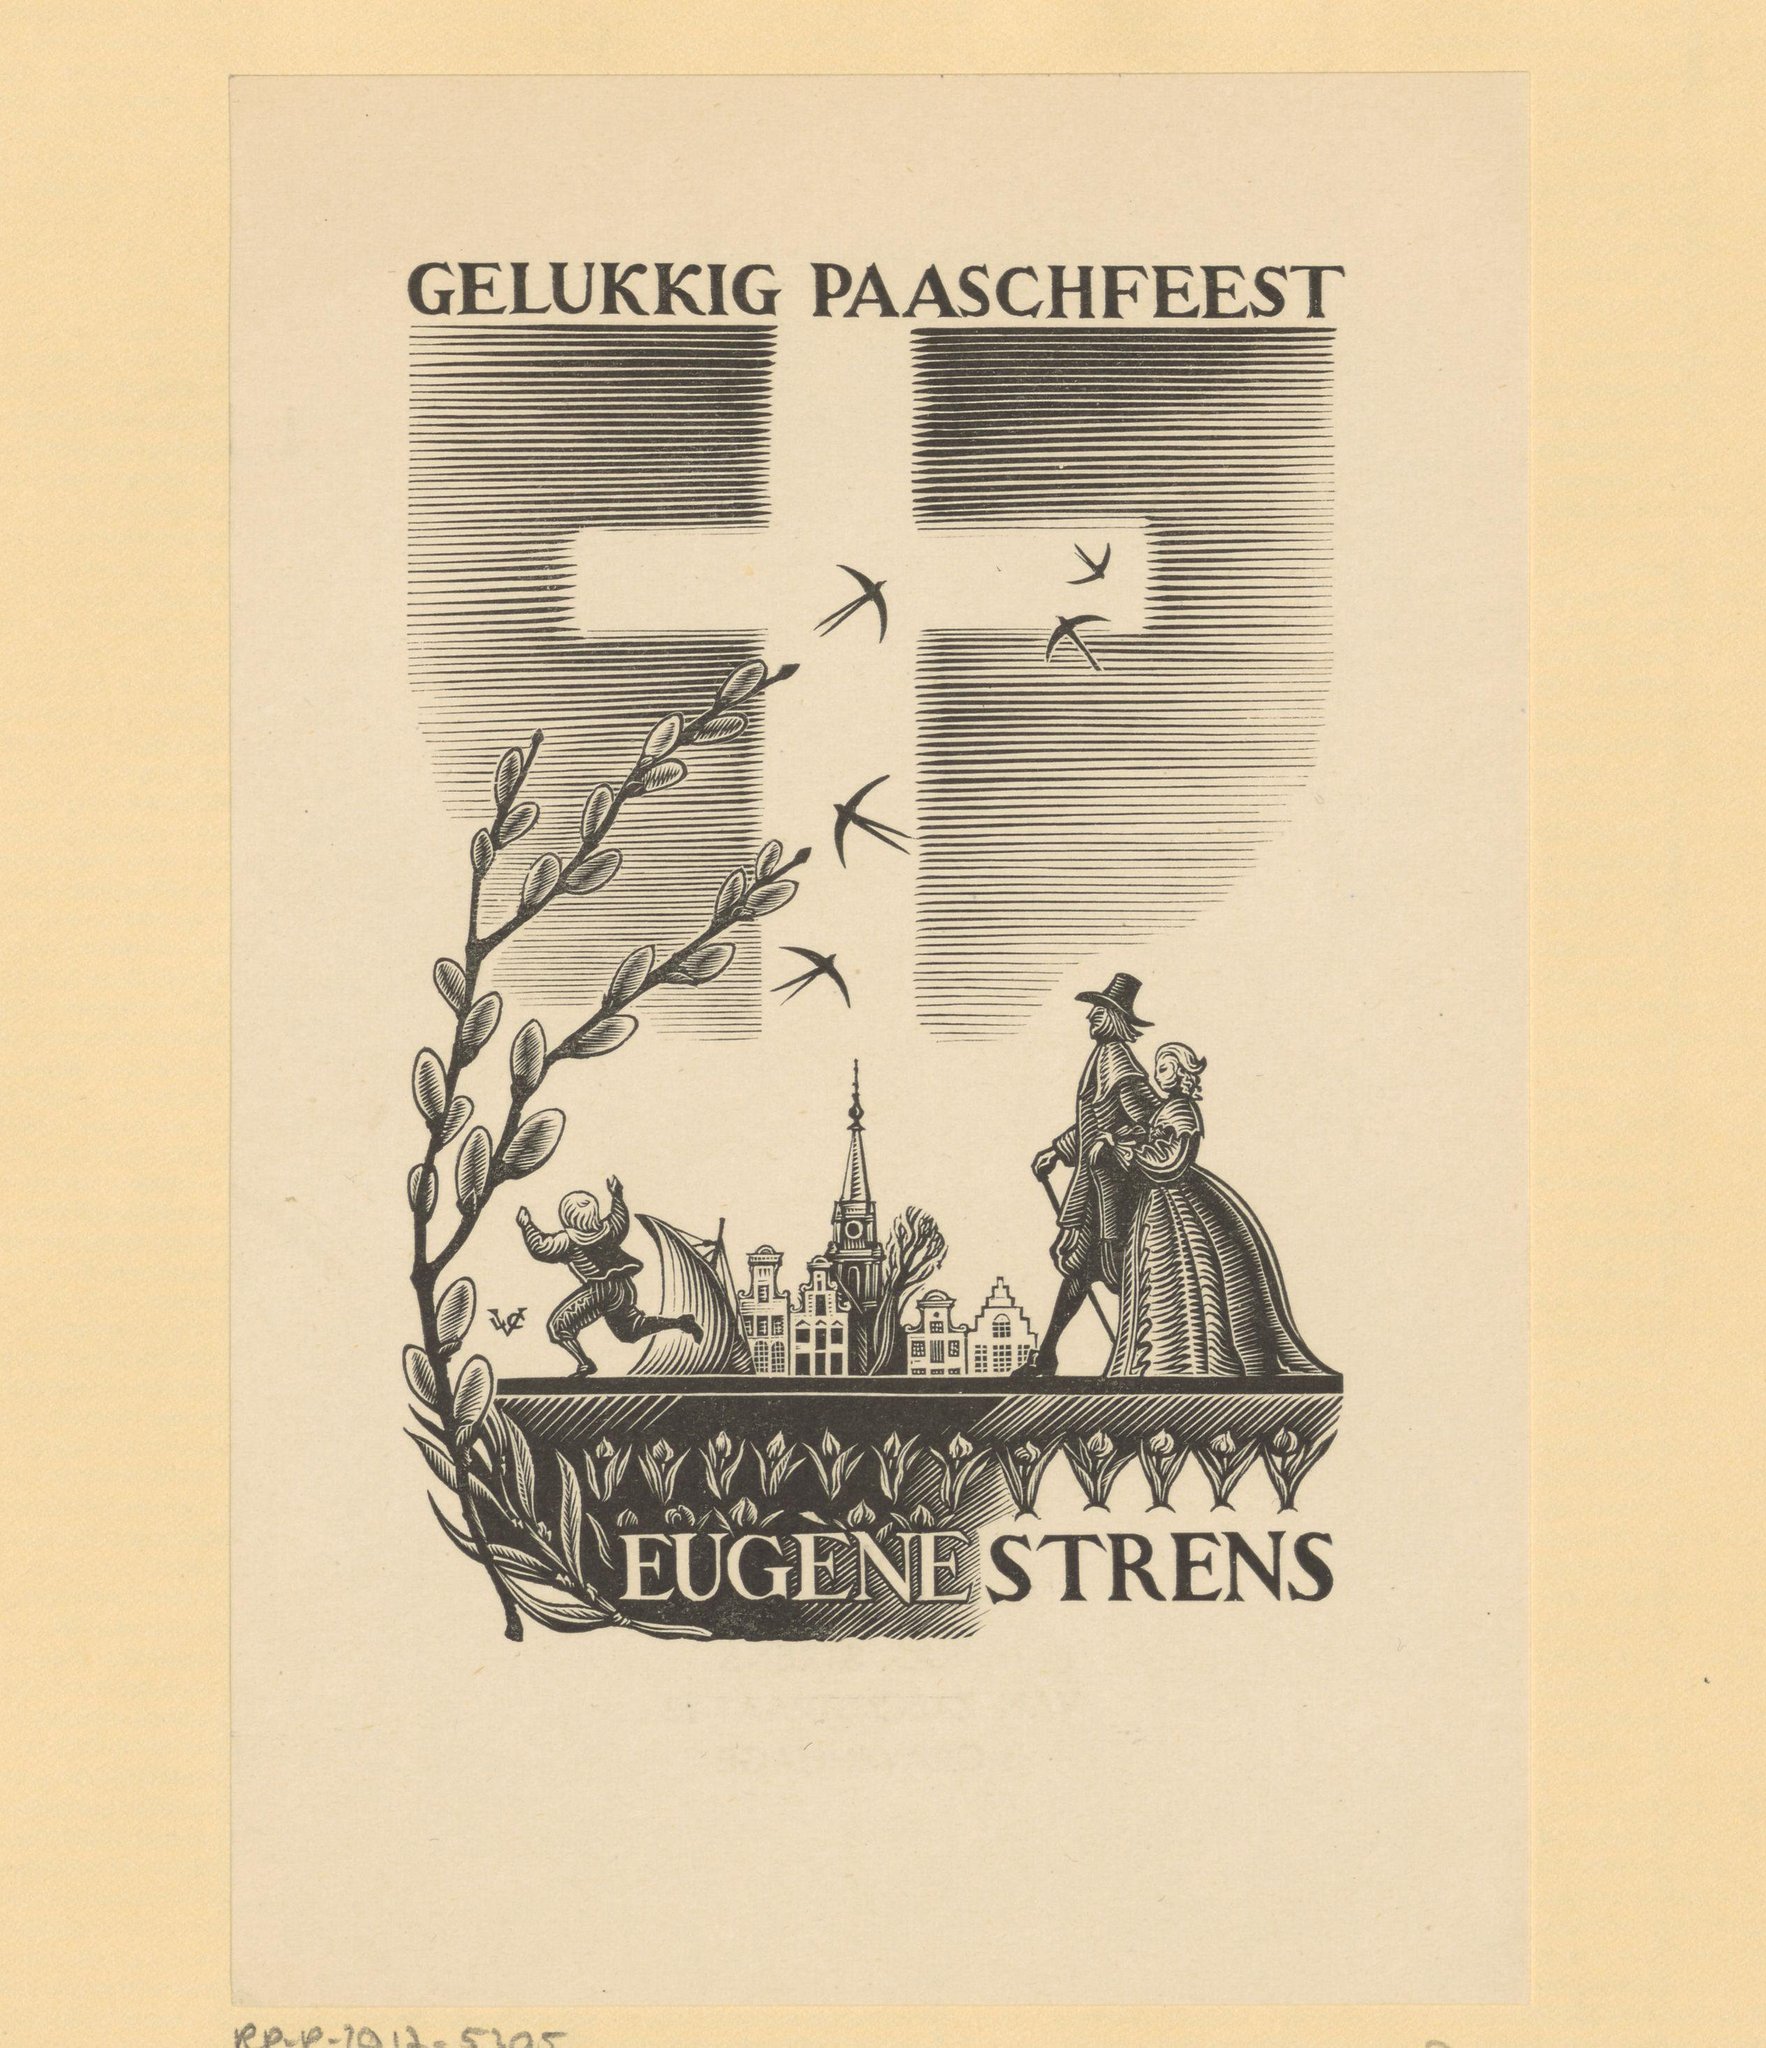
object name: easter card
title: Paasgroet van Eugène Strens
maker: valentin le campion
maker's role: print maker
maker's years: 1861-1952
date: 1936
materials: paper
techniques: engraving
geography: france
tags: eugène louis charles marie strens, boy (child between toddler and youth), the cross ~ symbols of christ, song-birds: swallow, historical costume, couple of lovers, prospect of city, town panorama, silhouette of city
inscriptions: inscription: ‘"Paaschwandeling" / houtgravure door / Valentin le Campion / Parijs / (van het houtblok gedrukt) / Ir. Eug. Strens / Van Zaeckstraat 13 / 's Gravenhage’